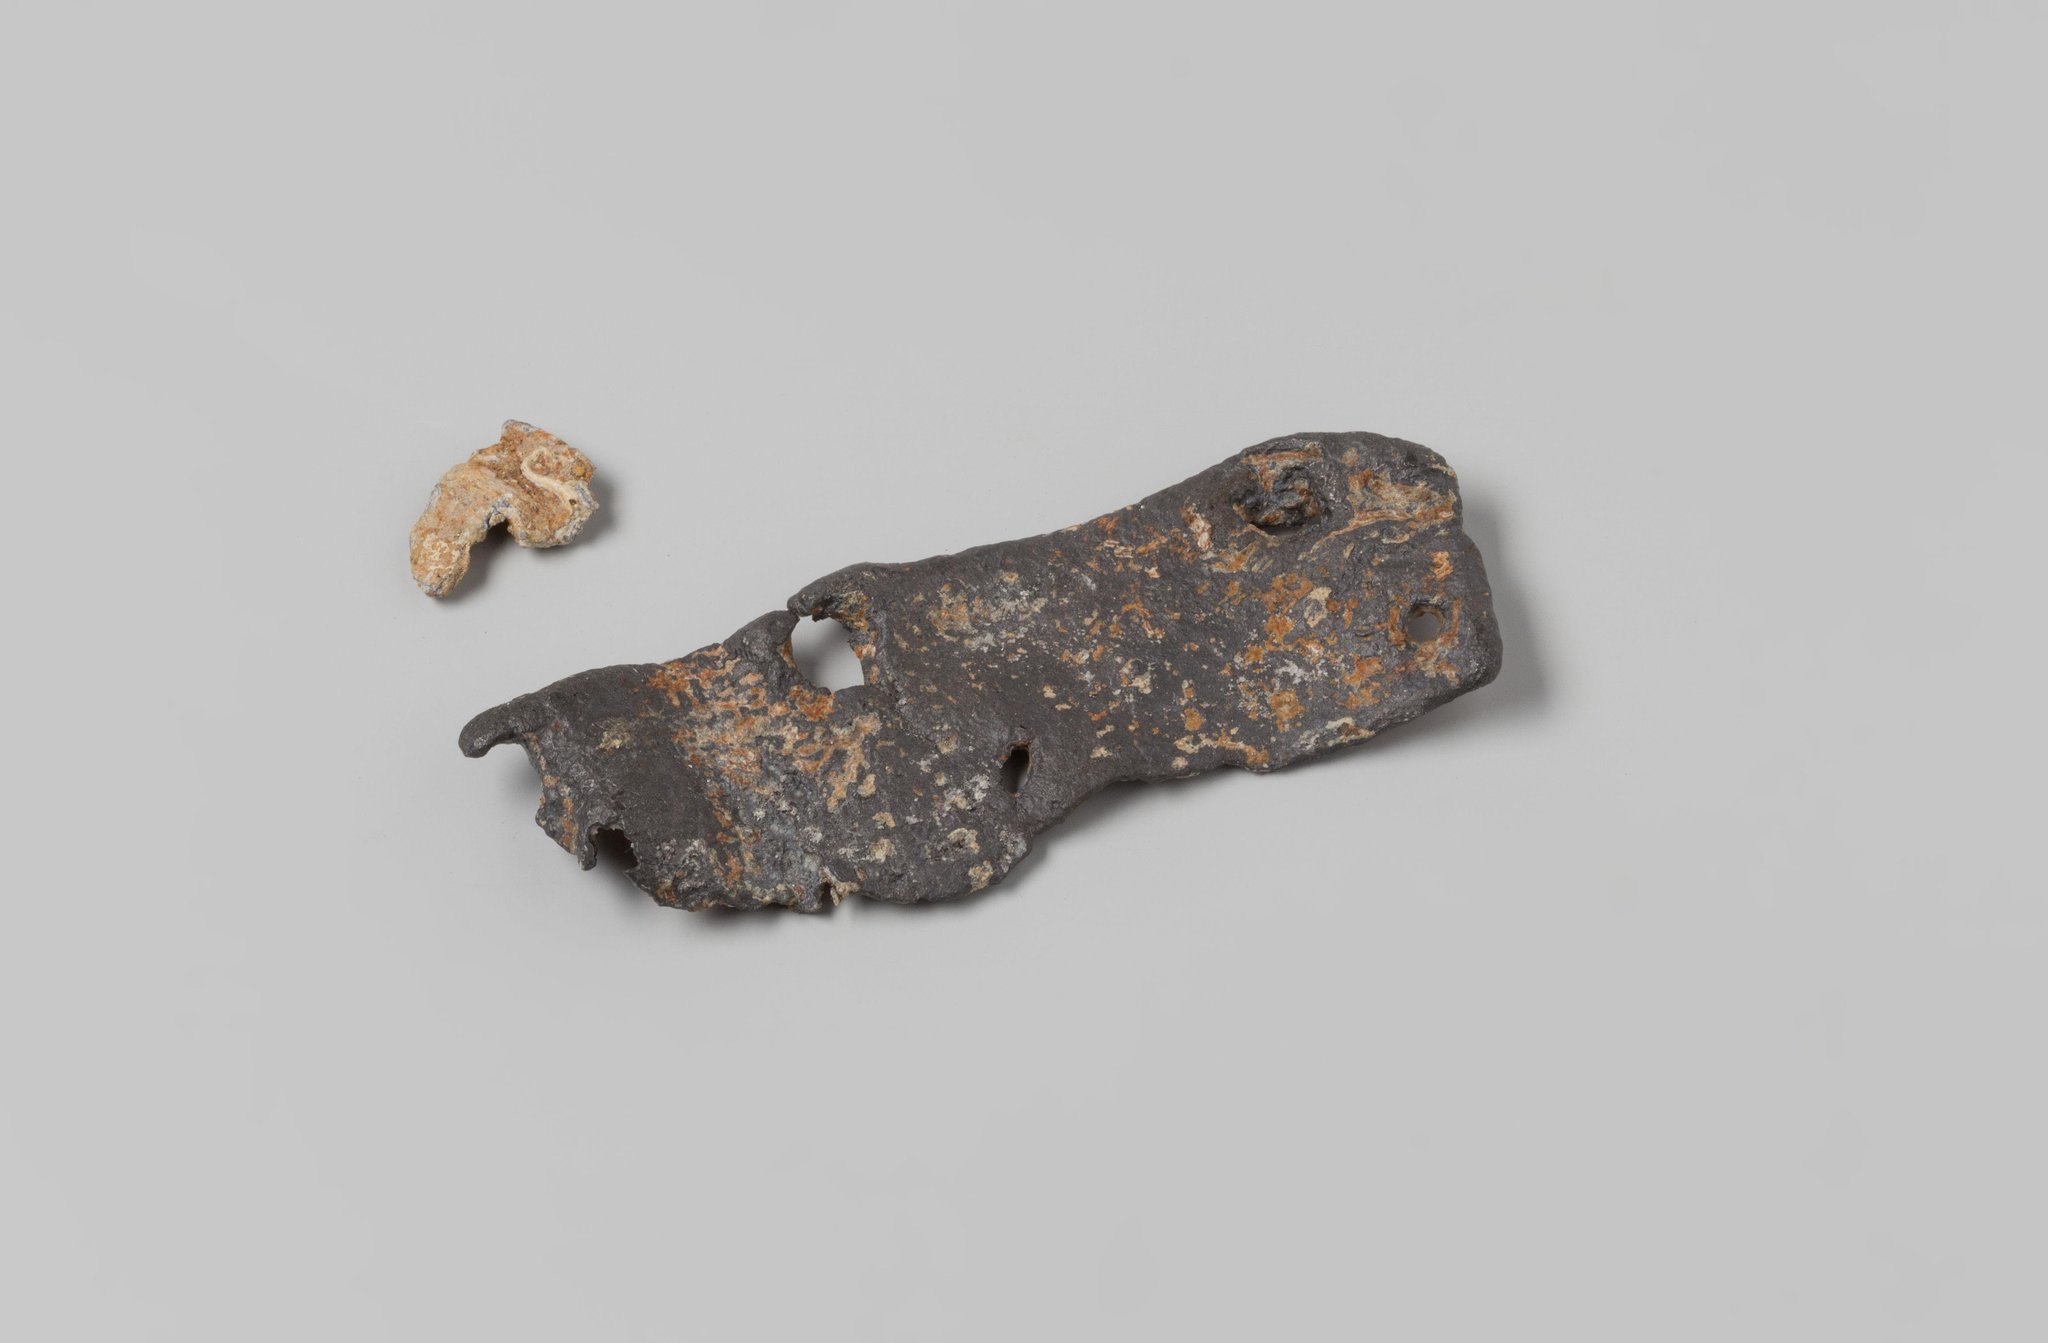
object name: fragment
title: Fragmenten plaatwerk uit het wrak van de Oost-Indiëvaarder Hollandia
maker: Anonymous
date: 1700-1743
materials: lead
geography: netherlands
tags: verenigde oostindische compagnie, hollandia (schip), annet